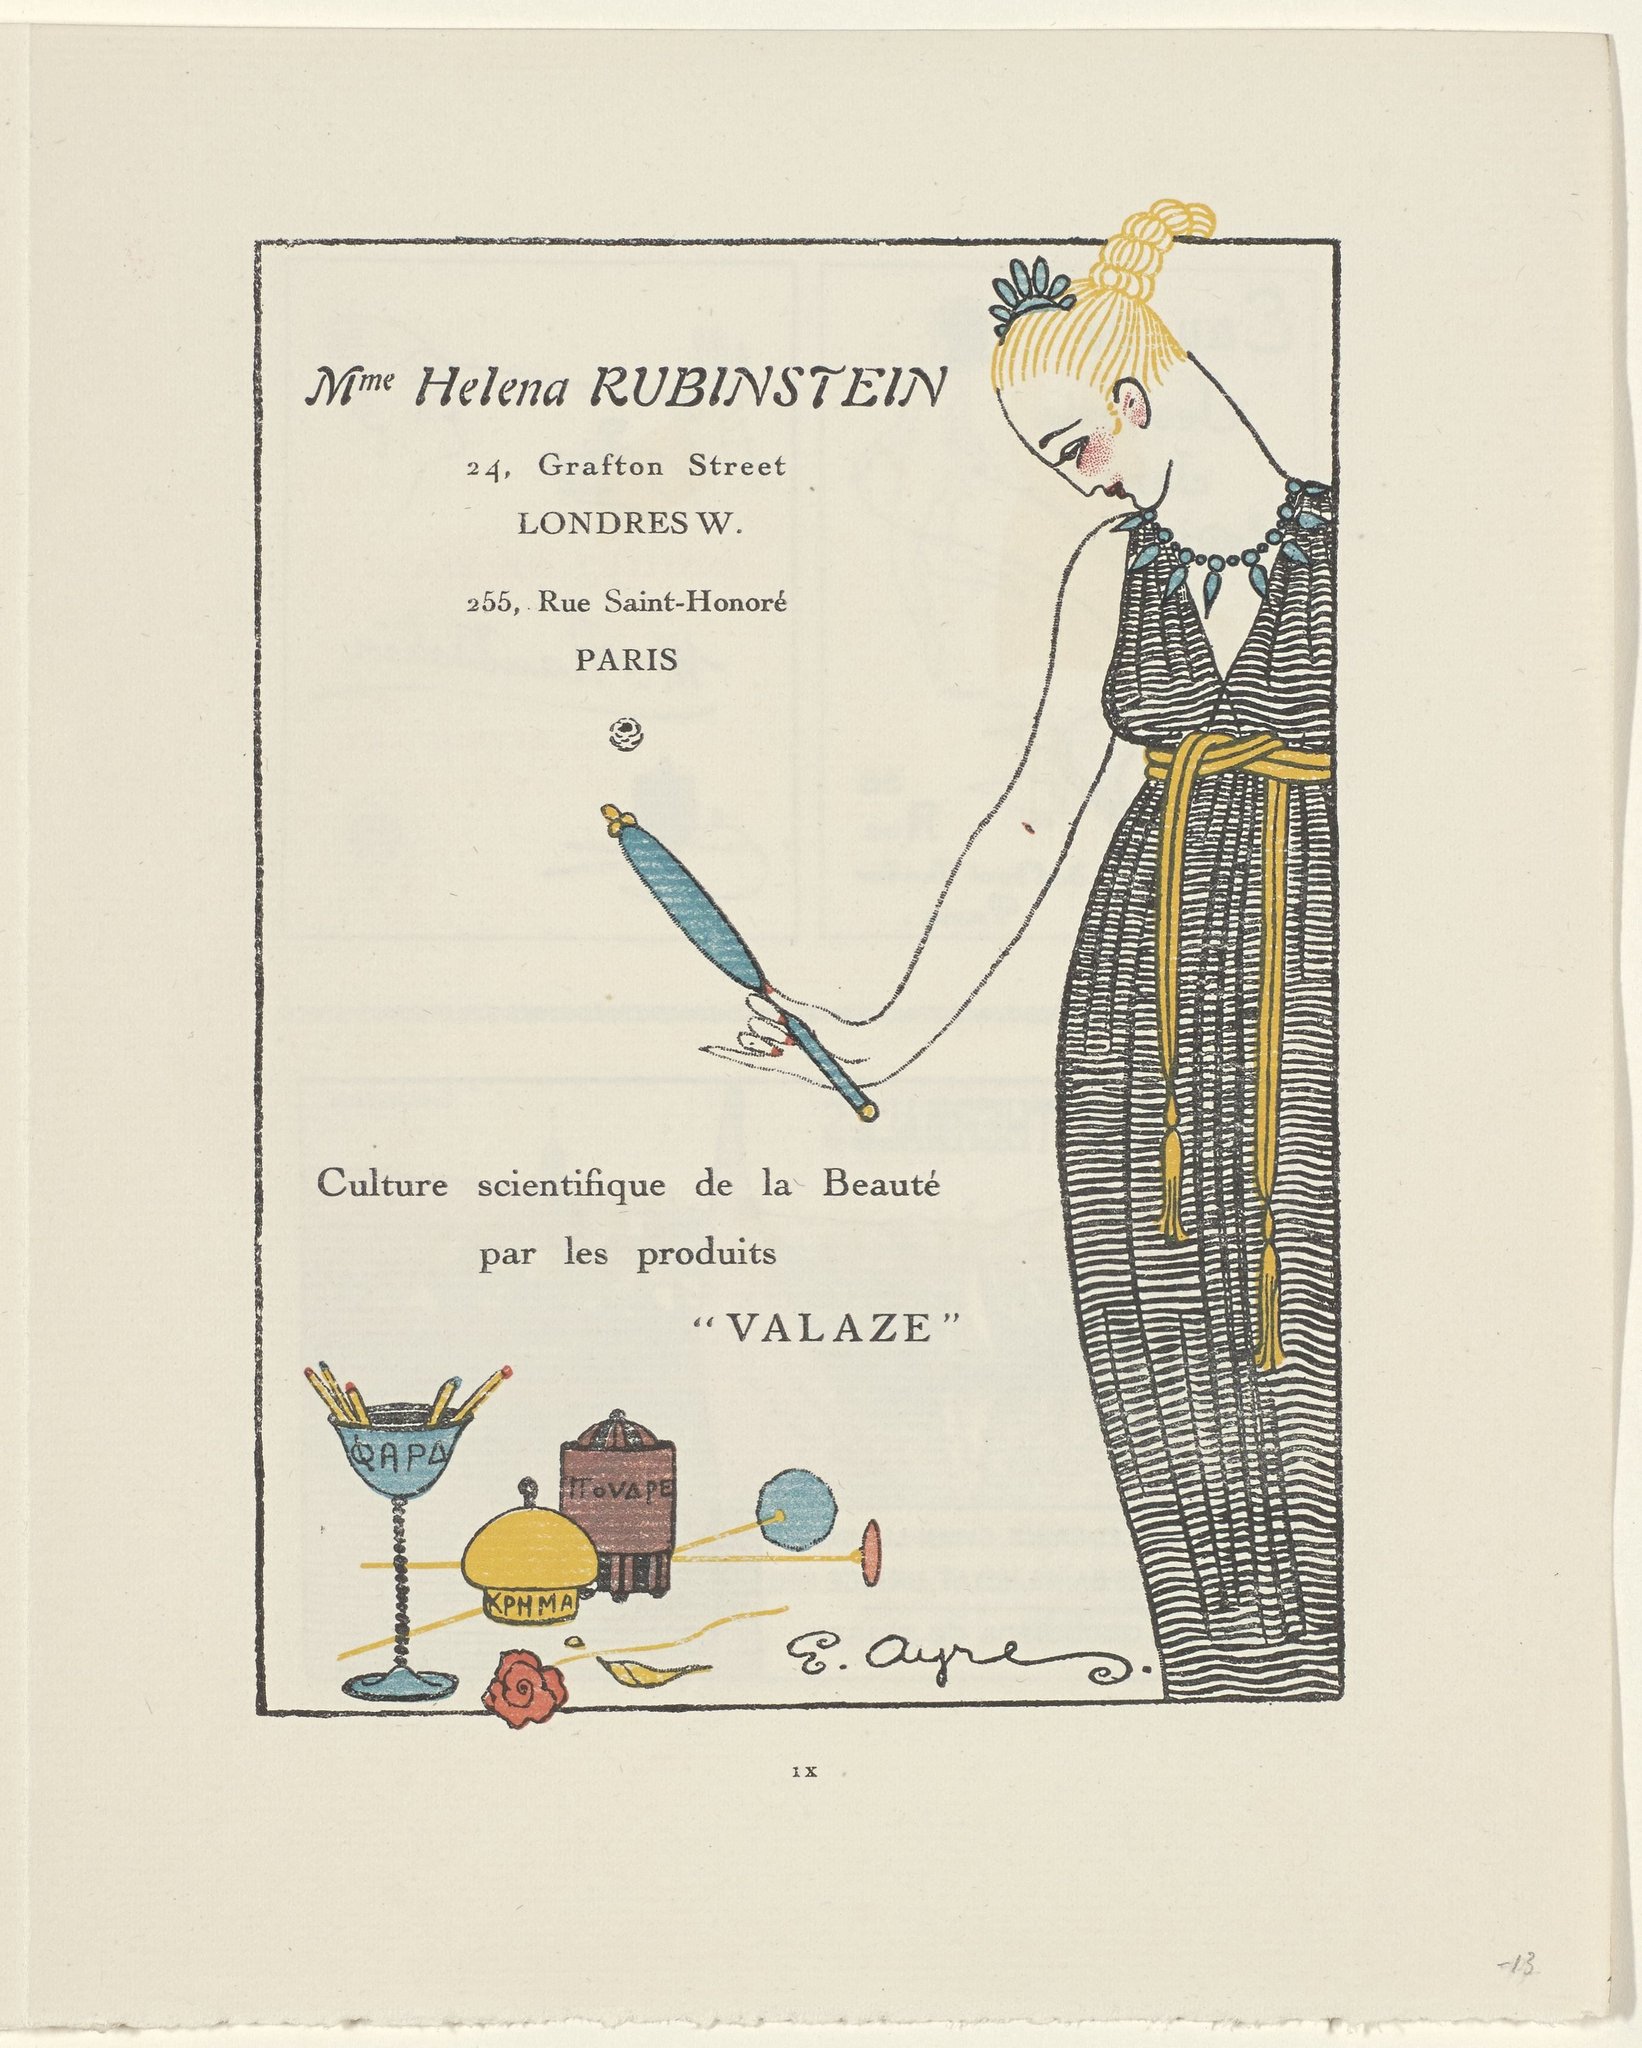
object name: fashion print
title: Gazette du Bon Ton, 1914 - No. 6, p. IX: Advertentie Helena Rubinstein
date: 1914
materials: paper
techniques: letterpress printing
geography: paris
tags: fashion plates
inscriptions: date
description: Advertentie Helena Rubinstein: producten "Valaze". Vrouw met handspiegel en potjes van "Valaze" . Pagina IX in Gazette du Bon Ton, 1914 - No. 6